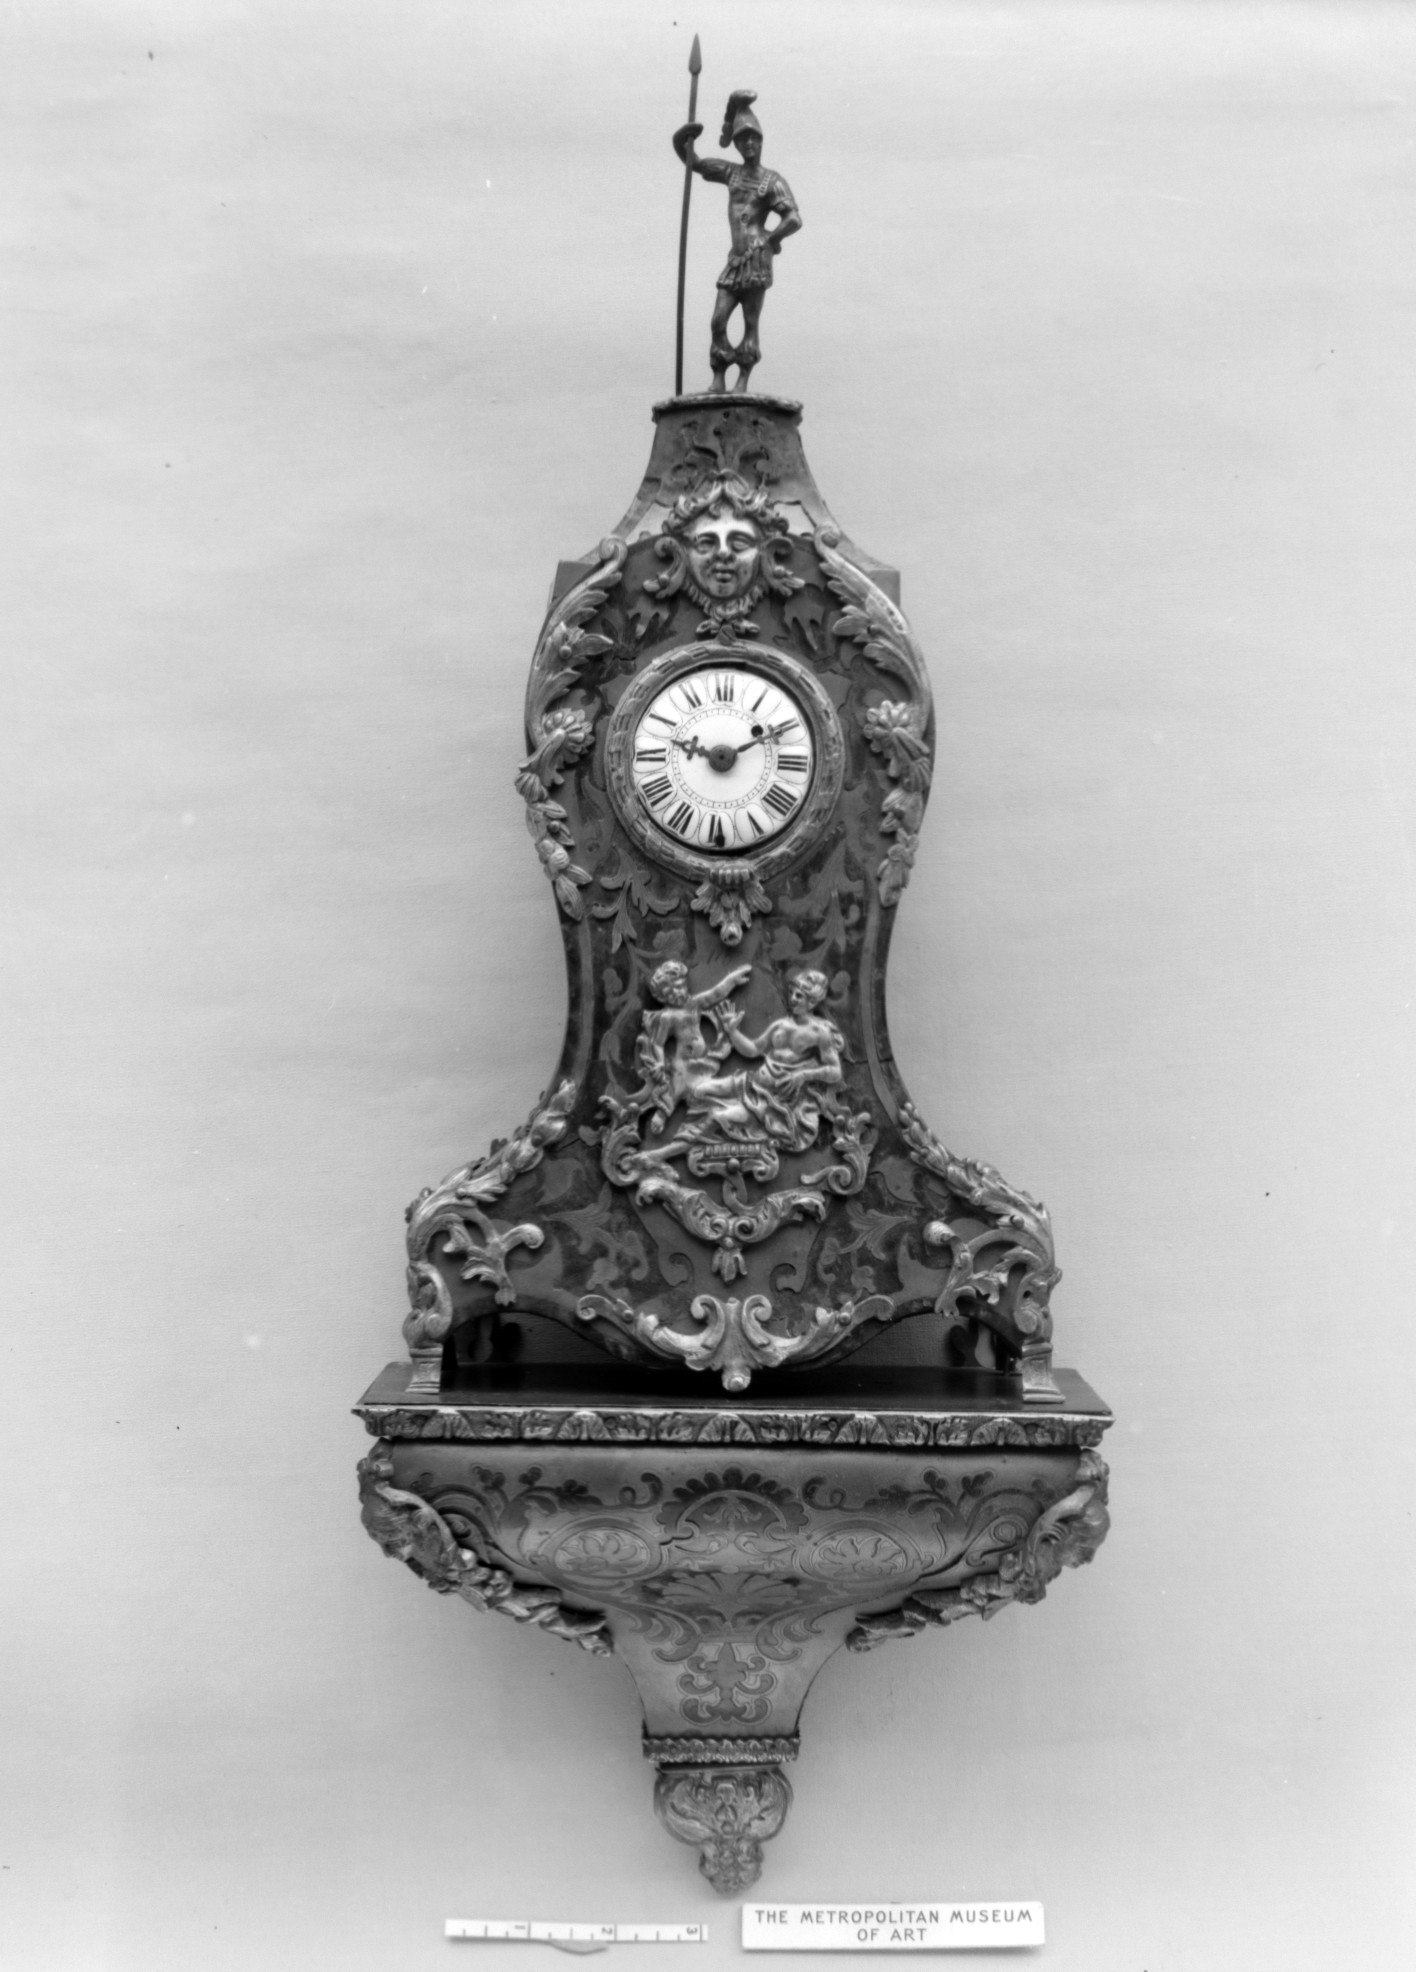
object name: clock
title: Clock with bracket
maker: gernier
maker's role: maker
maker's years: 1700-1800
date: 1734-1766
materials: brass, enamel, wood